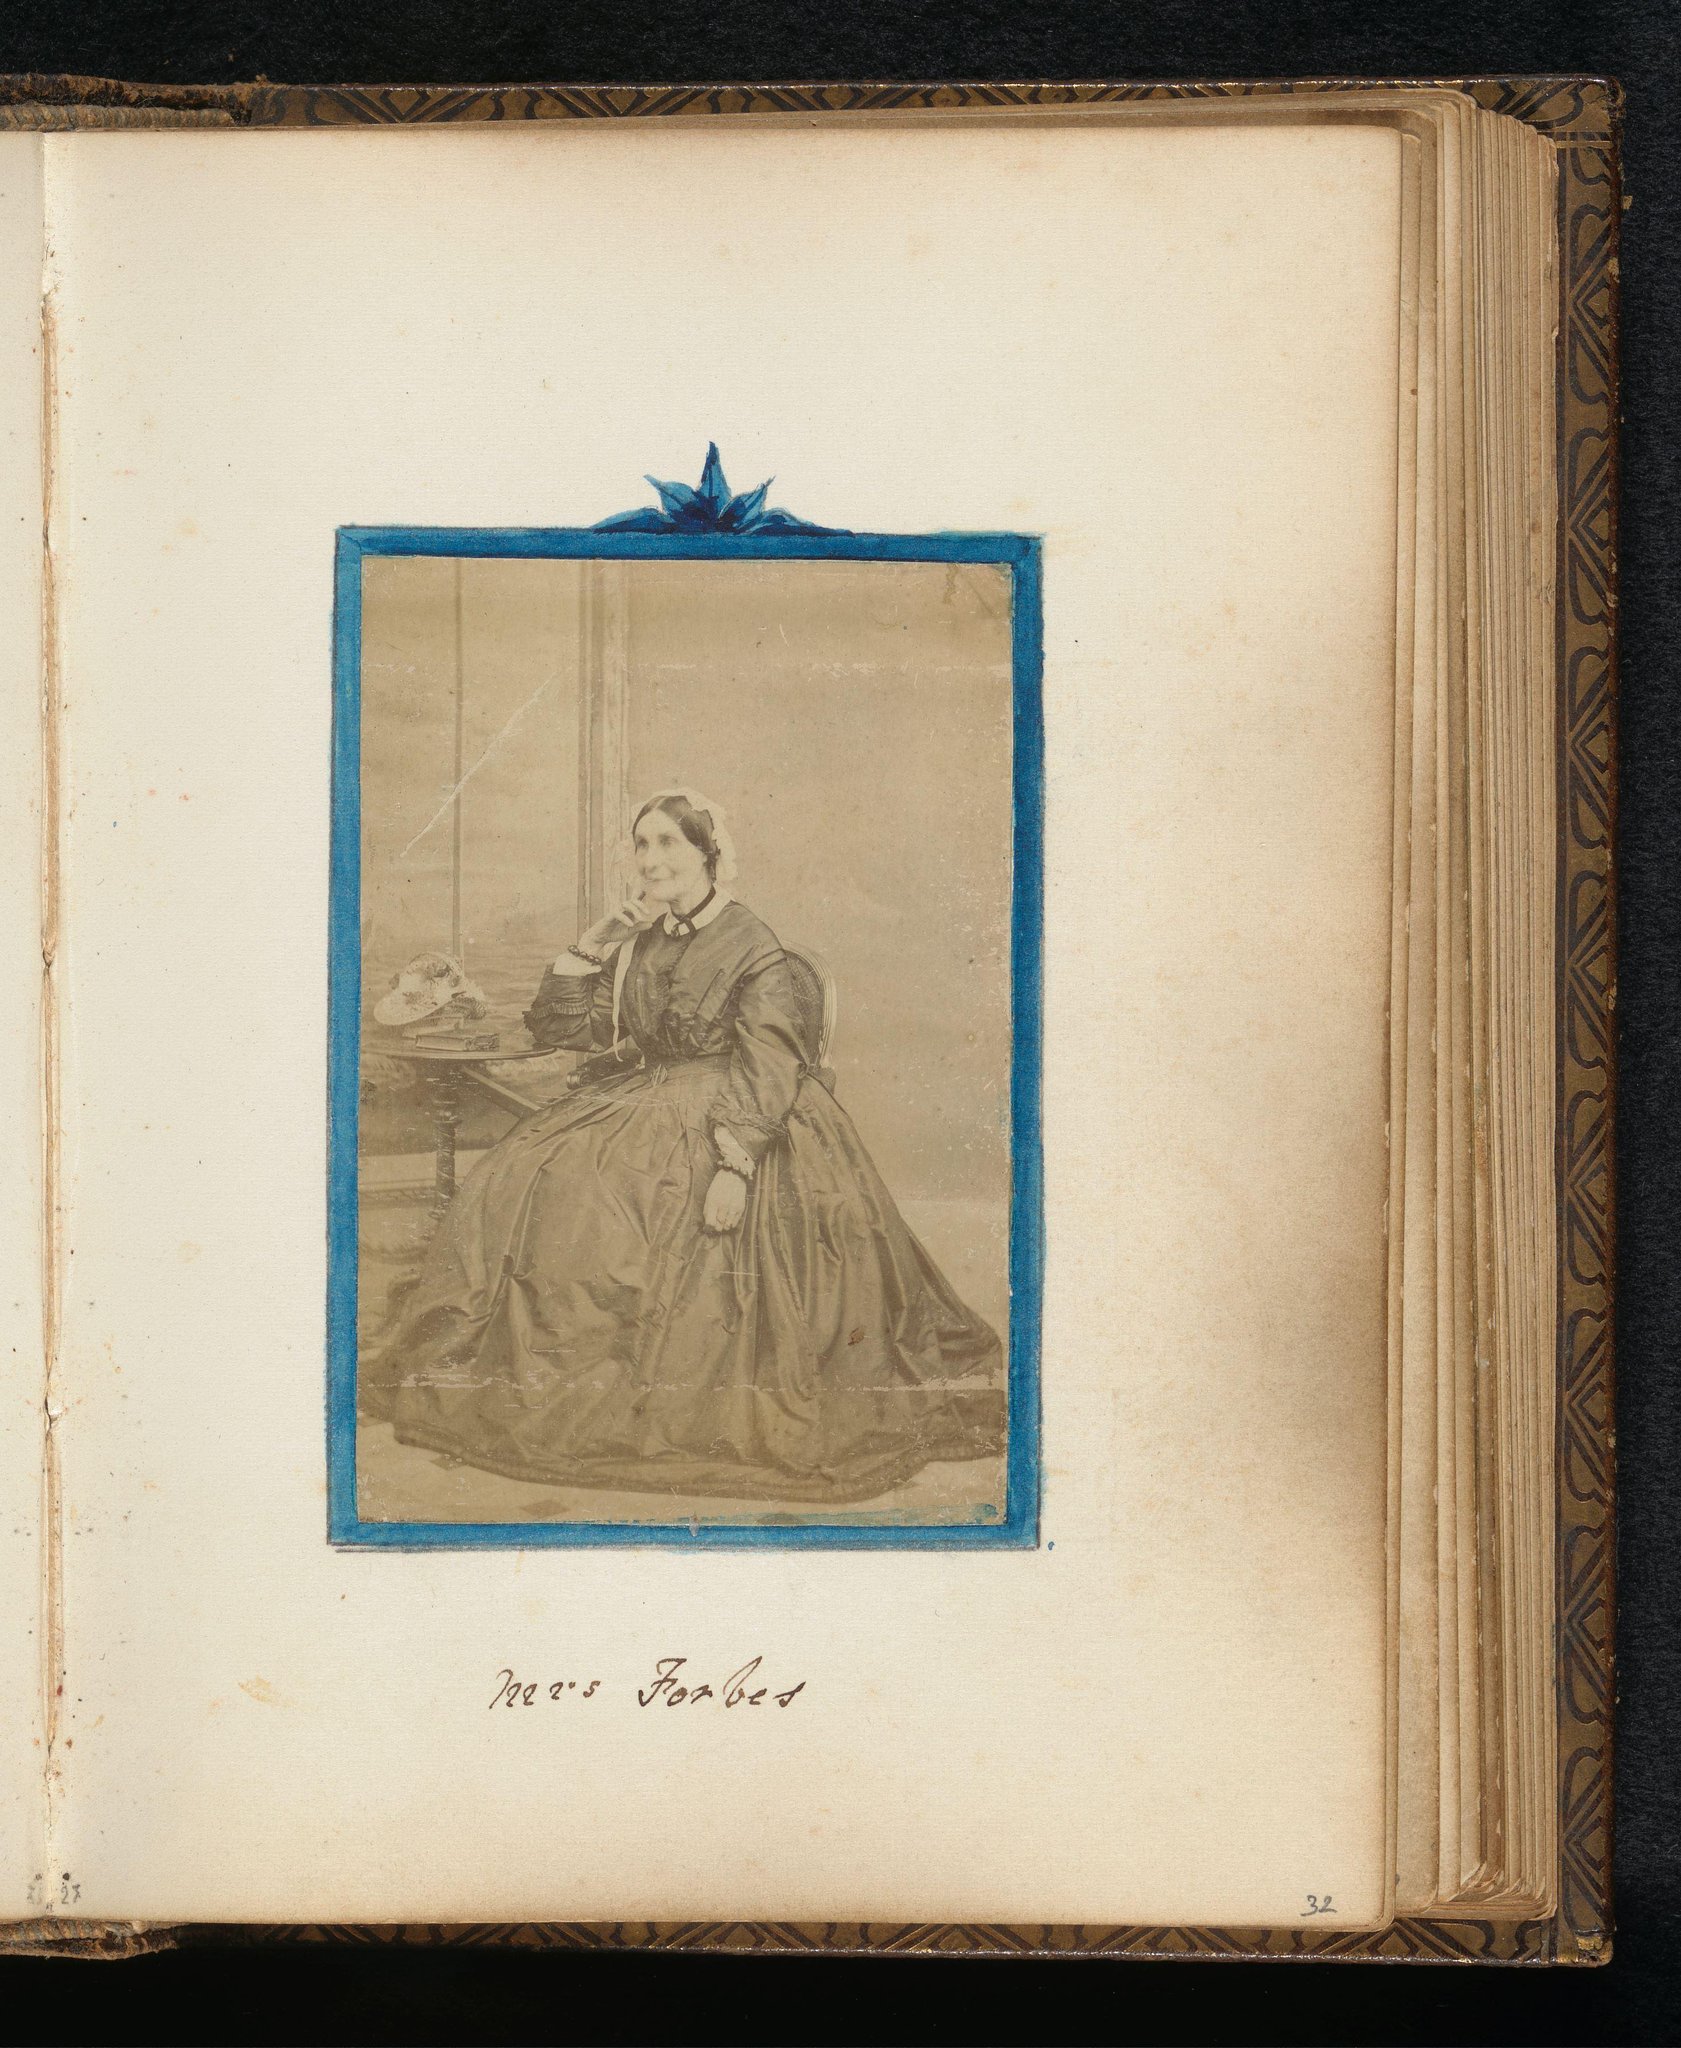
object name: carte de visite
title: Mrs Forbes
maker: Anonymous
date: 1865-1867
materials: cardboard, photographic support, watercolor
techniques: albumen print, aquarelle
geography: england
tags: historical persons - bb - woman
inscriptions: annotation: ‘Mrs Forbes’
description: Portret van Mrs Forbes. Foto op albumblad in album met 68 foto's merendeels met geaquarelleerde randversieringen. Het zijn voornamelijk portretten op carte-de-visite formaat.